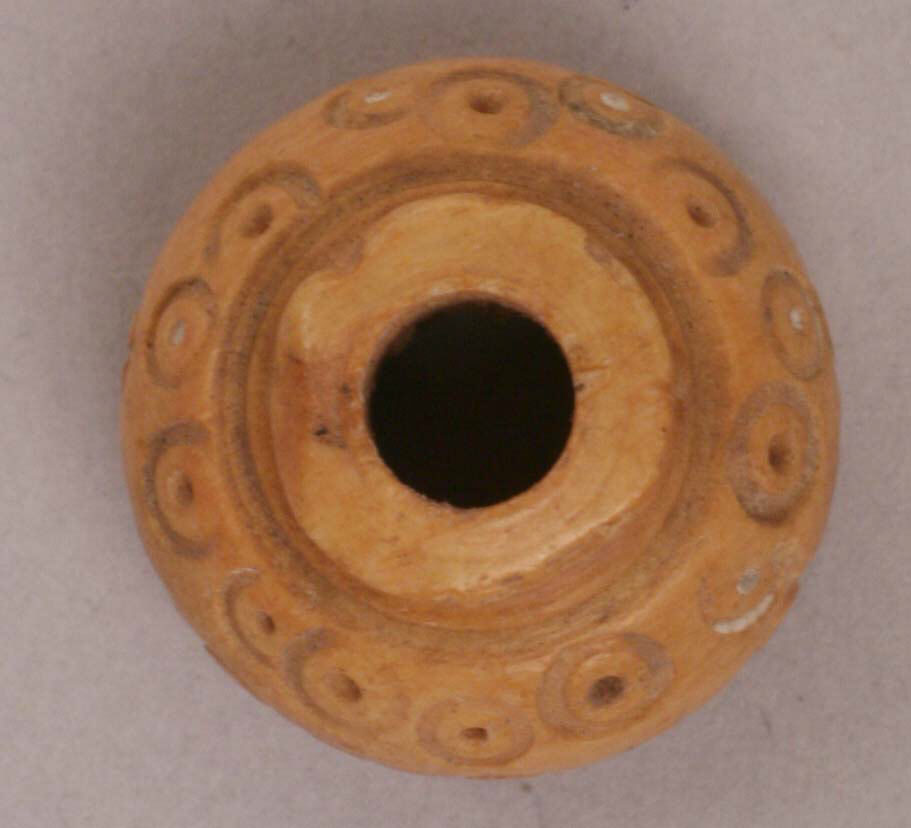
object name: button or bead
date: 801-1000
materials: bone, paint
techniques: incising, inlay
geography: iran